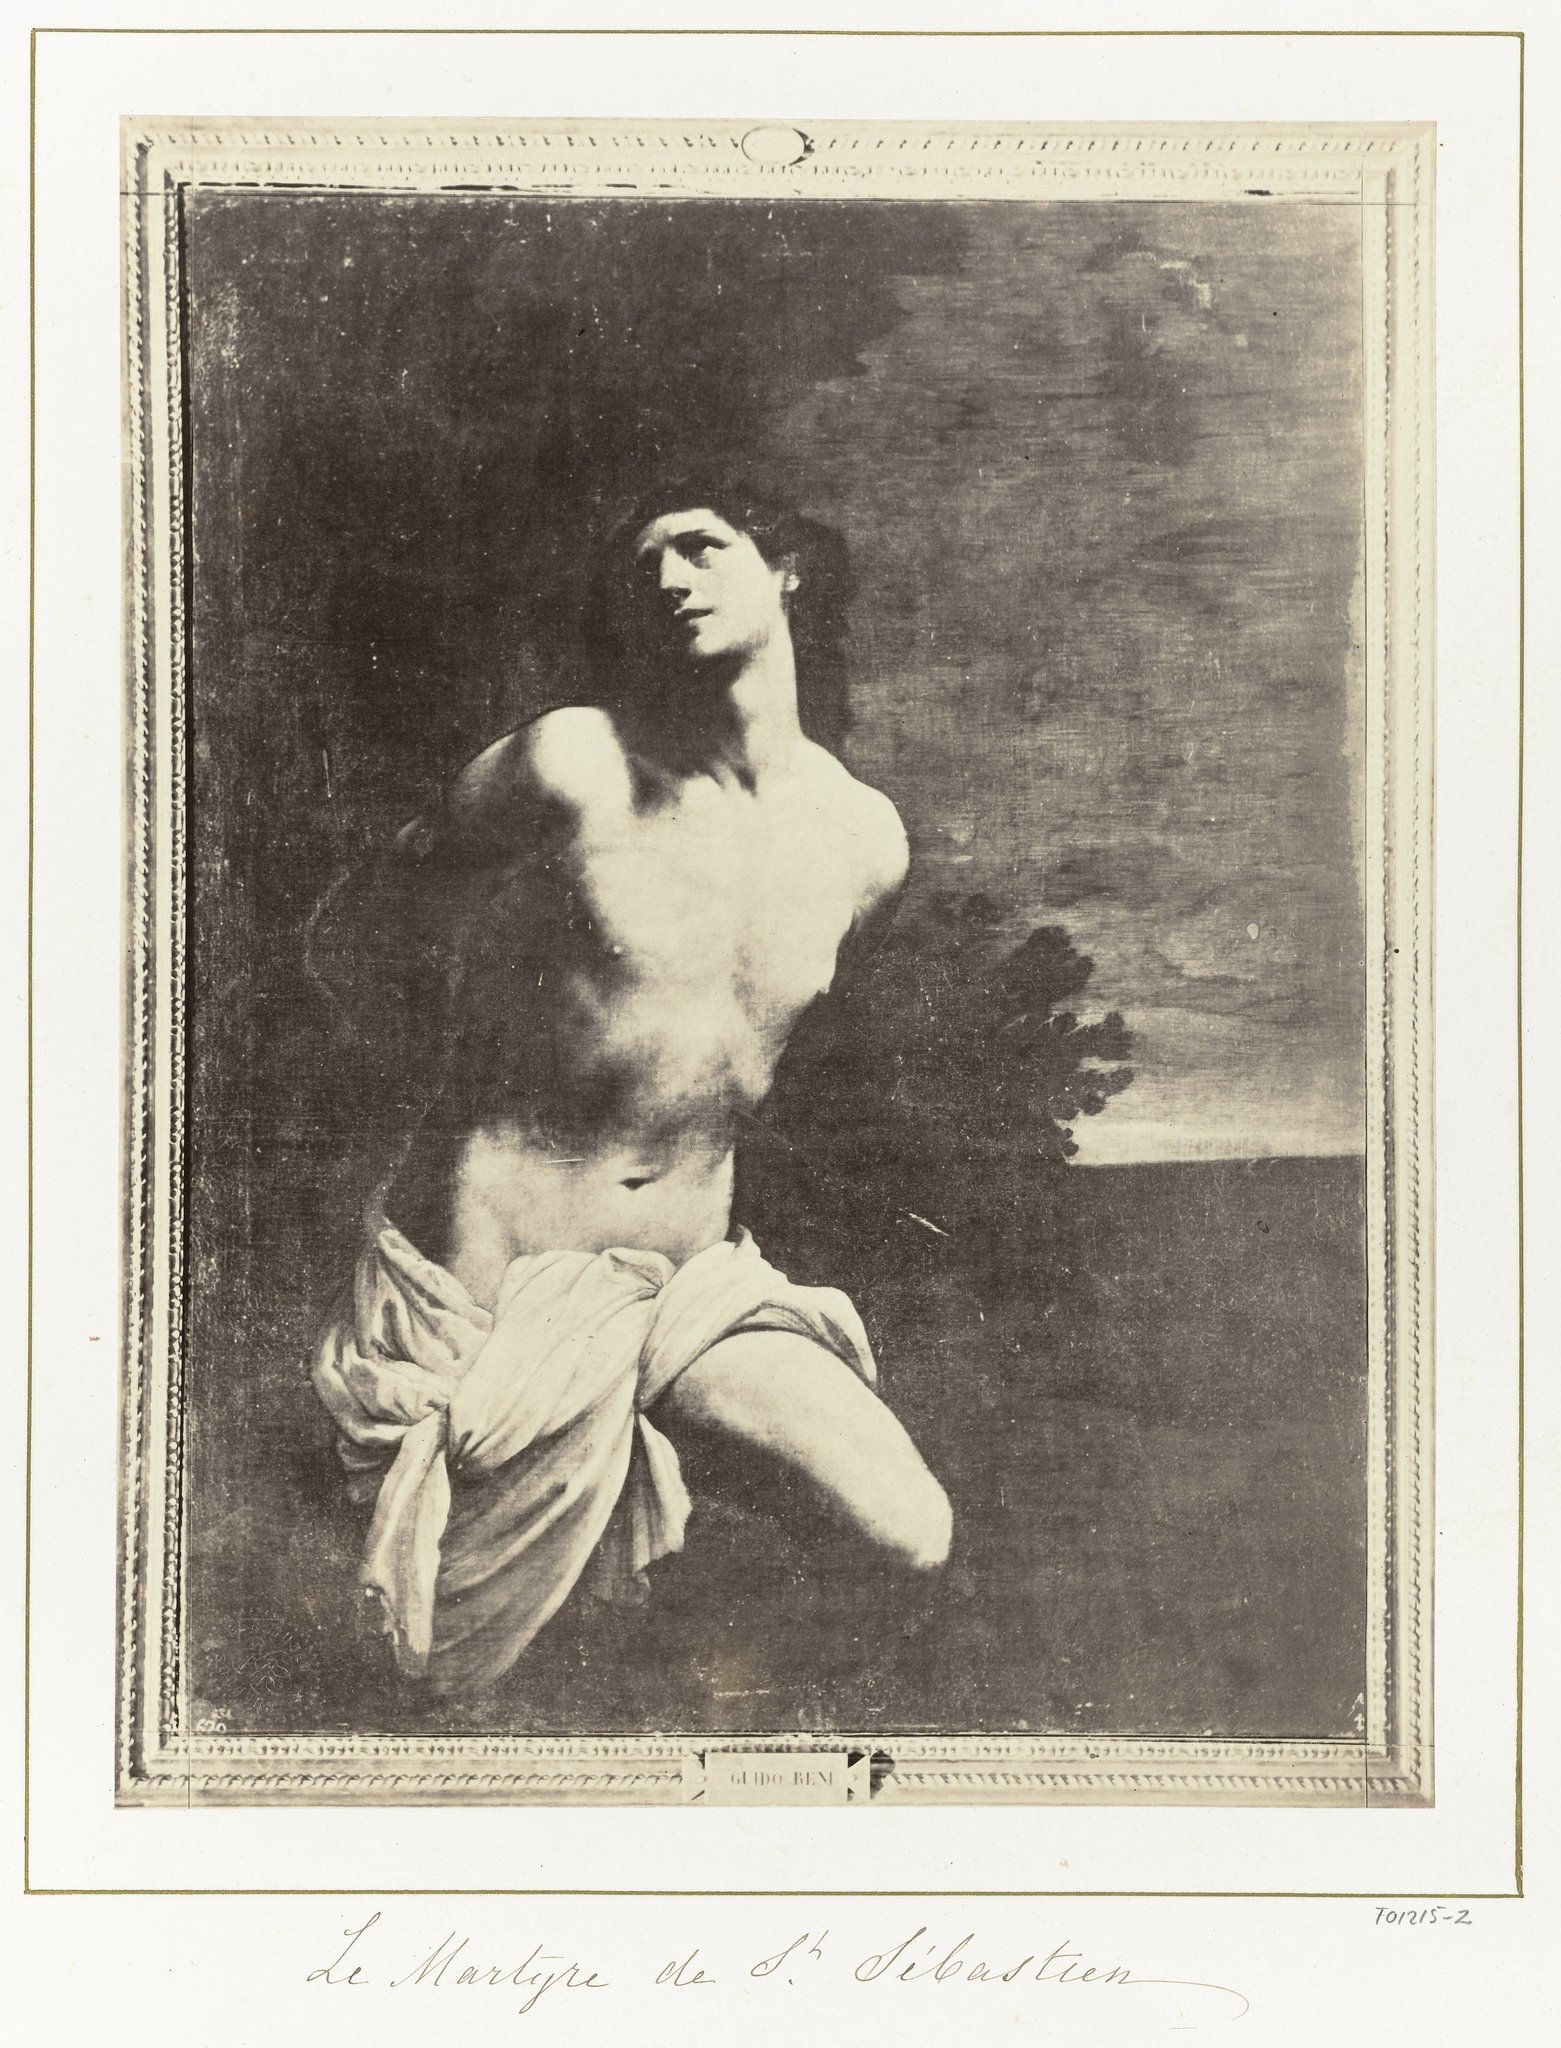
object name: reproduction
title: Fotoreproductie van een schilderij door Guido Reni, voorstellend het martelaarschap van de heilige Sebastiaan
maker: Anonymous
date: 1860-1875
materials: photographic support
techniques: albumen print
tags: the martyr sebastian; possible attributes: arrow(s), bow, tree-trunk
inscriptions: inscription: ‘cuadros del Rl. Museo M[...]’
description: Onderdeel van Reisalbum met opnames van kunstwerken, personen en bezienswaardigheden in Spanje.